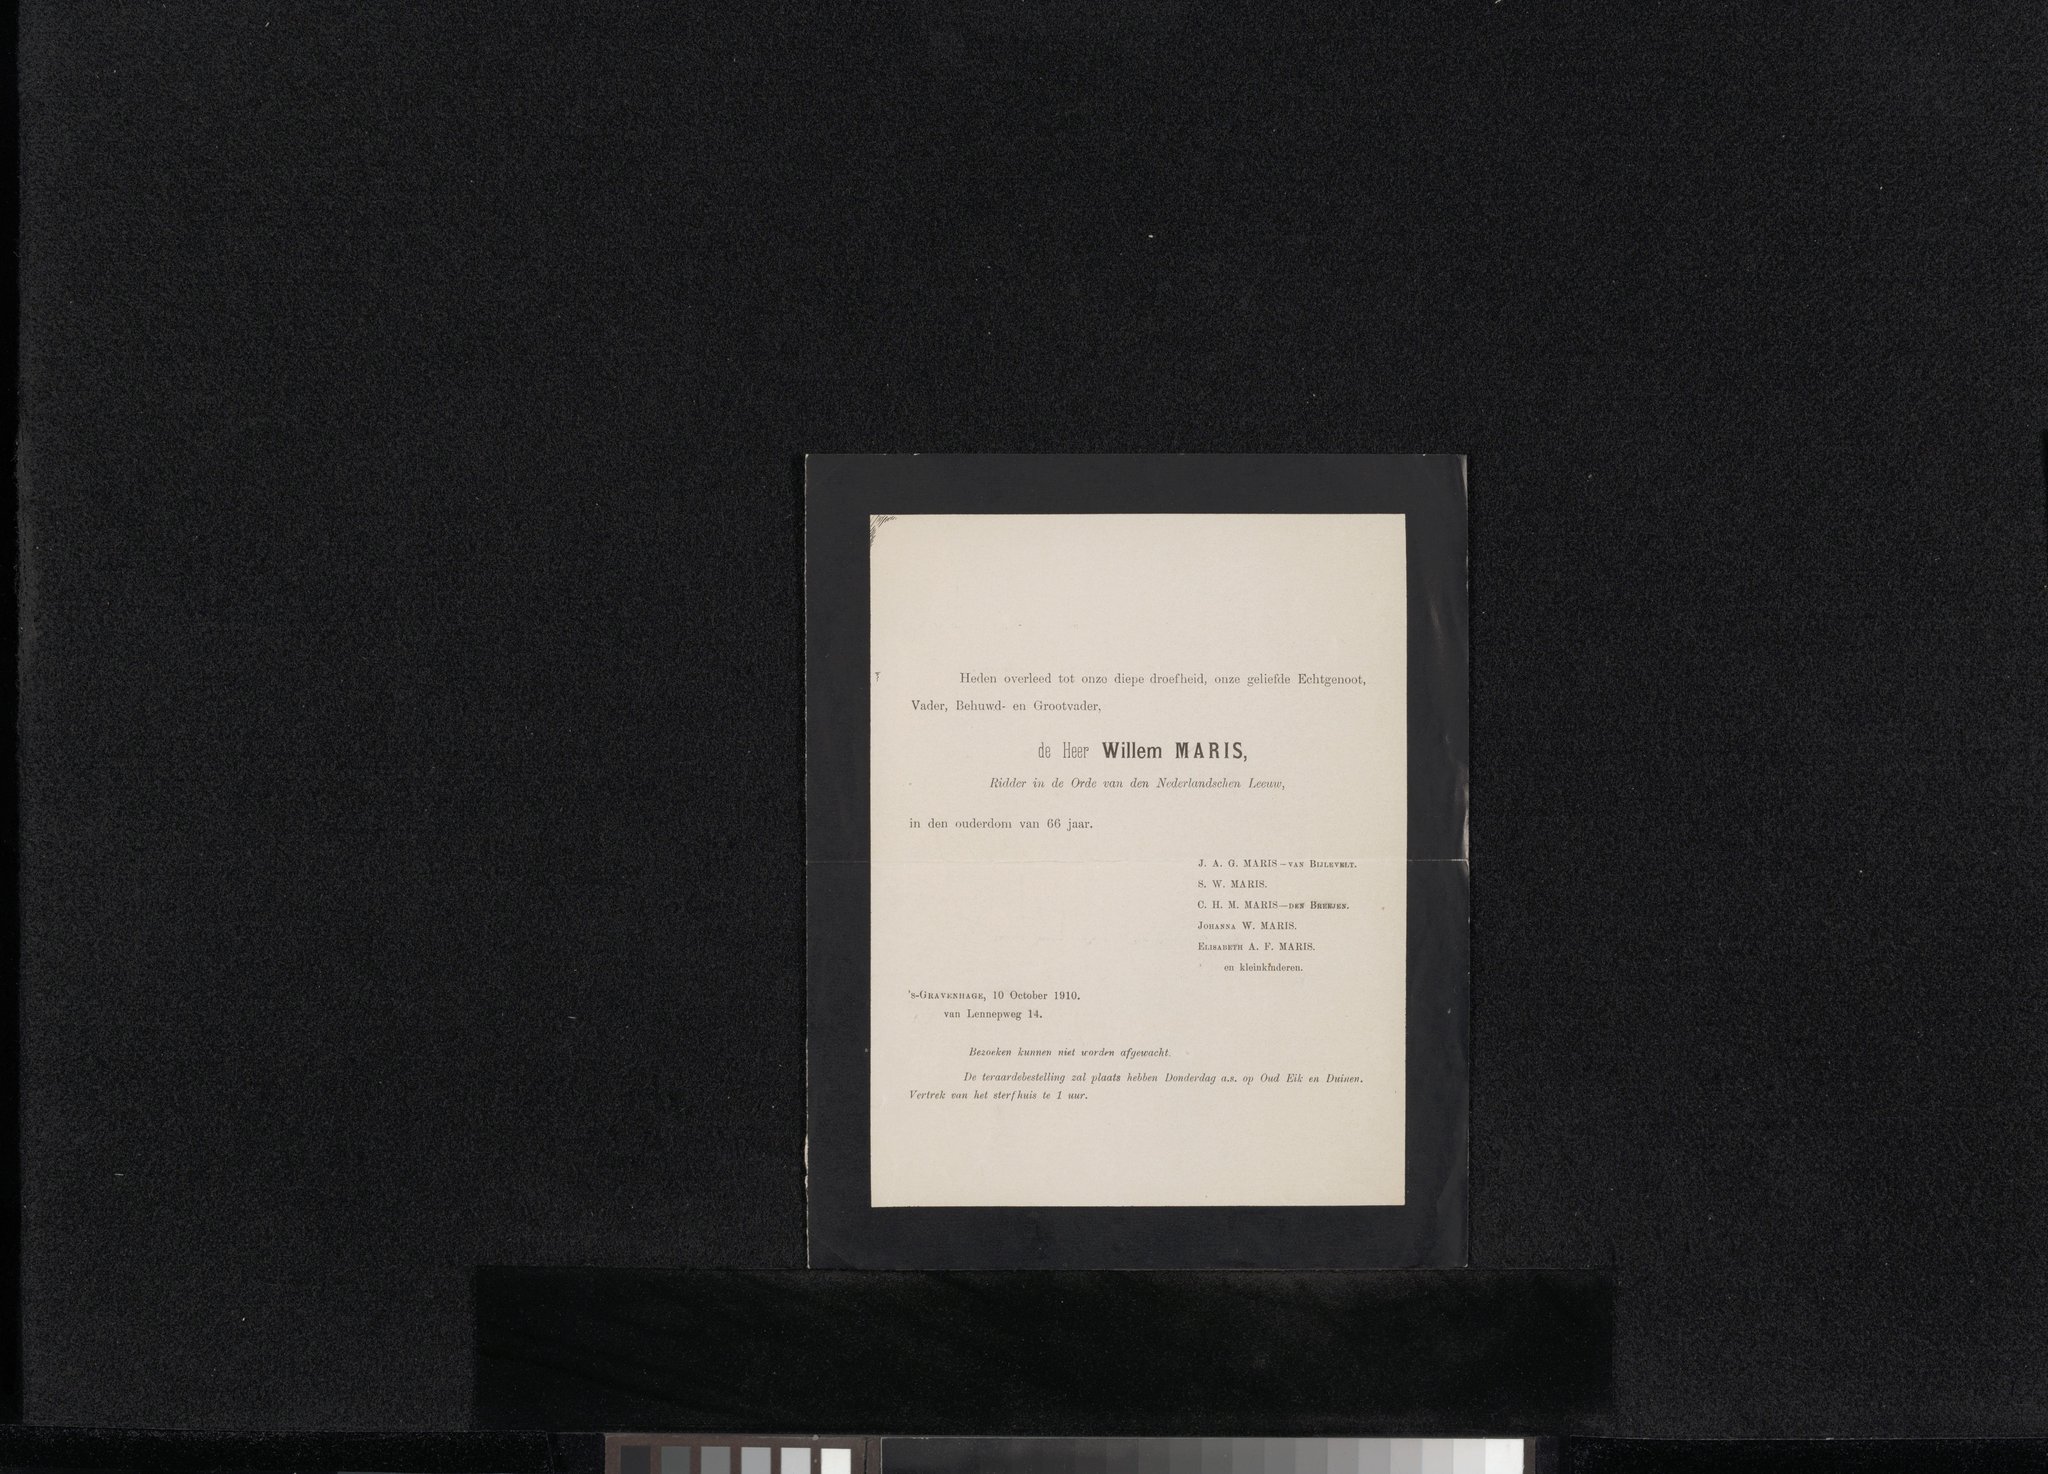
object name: overlijdensbericht, overlijdensadvertentie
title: Overlijdensbericht betreffende Willem Maris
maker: Anonymous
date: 1910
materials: paper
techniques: printing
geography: the hague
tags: the hague, painter, draughtsman, willem maris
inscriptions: collector's mark: ‘RPK’